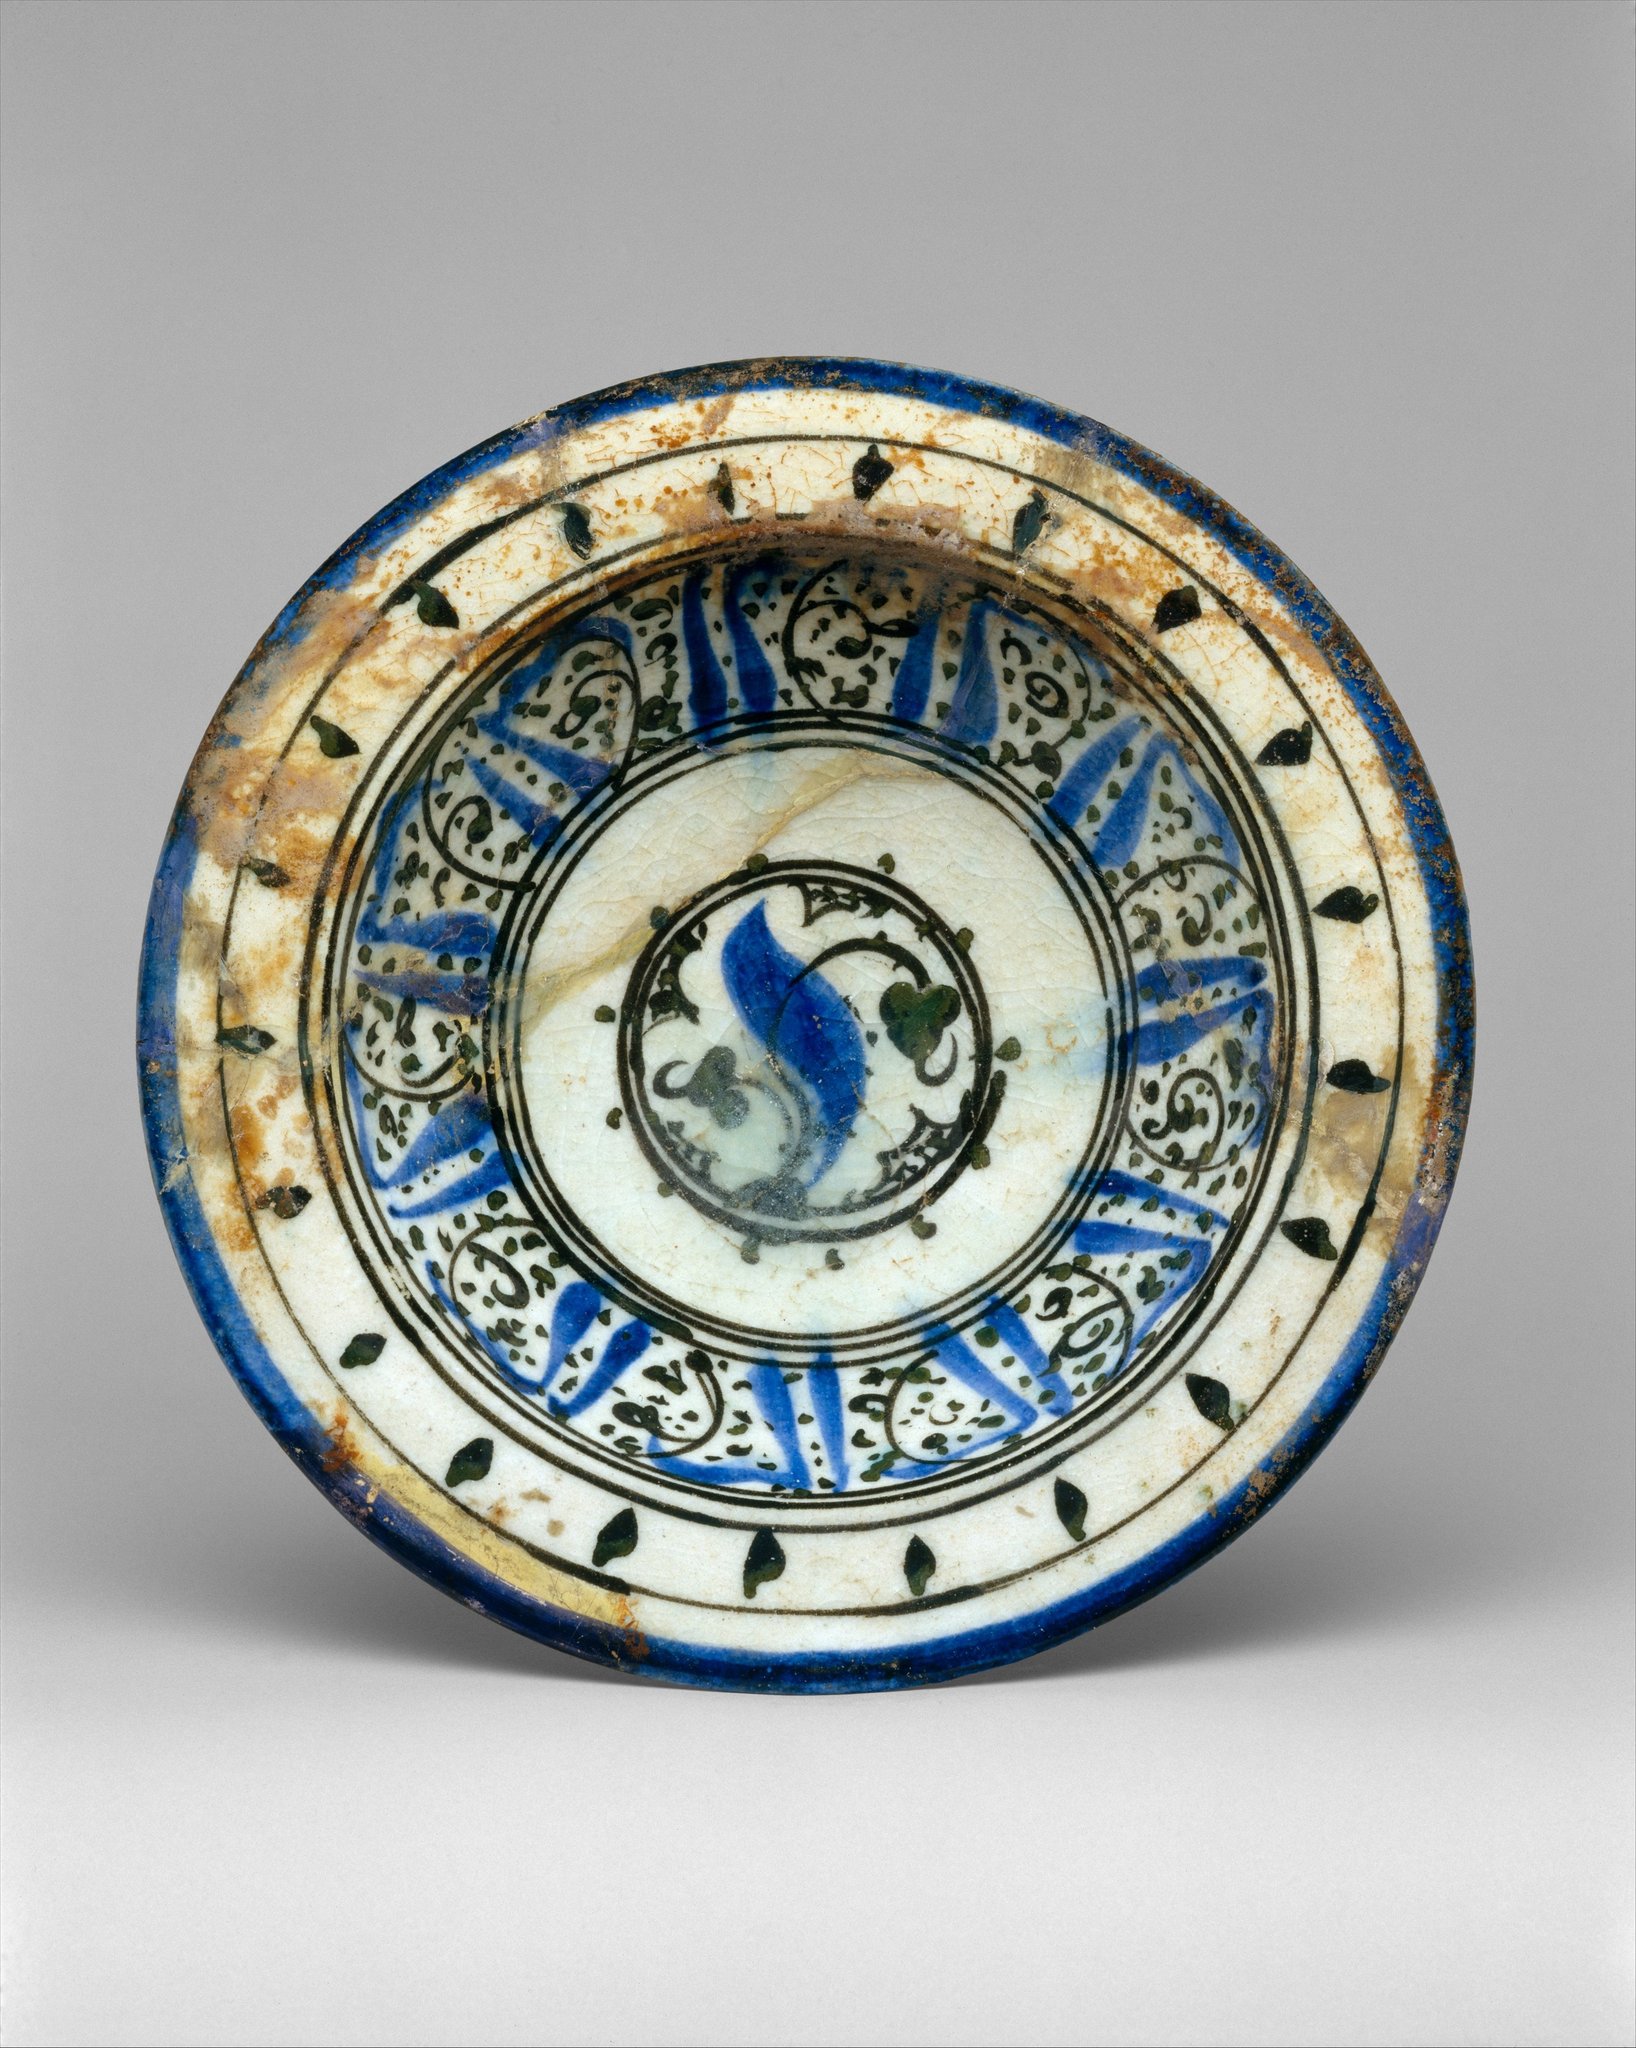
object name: bowl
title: Bowl with Pseudo-inscription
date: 1201-1300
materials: glaze, stonepaste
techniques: painting, polychrome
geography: syria